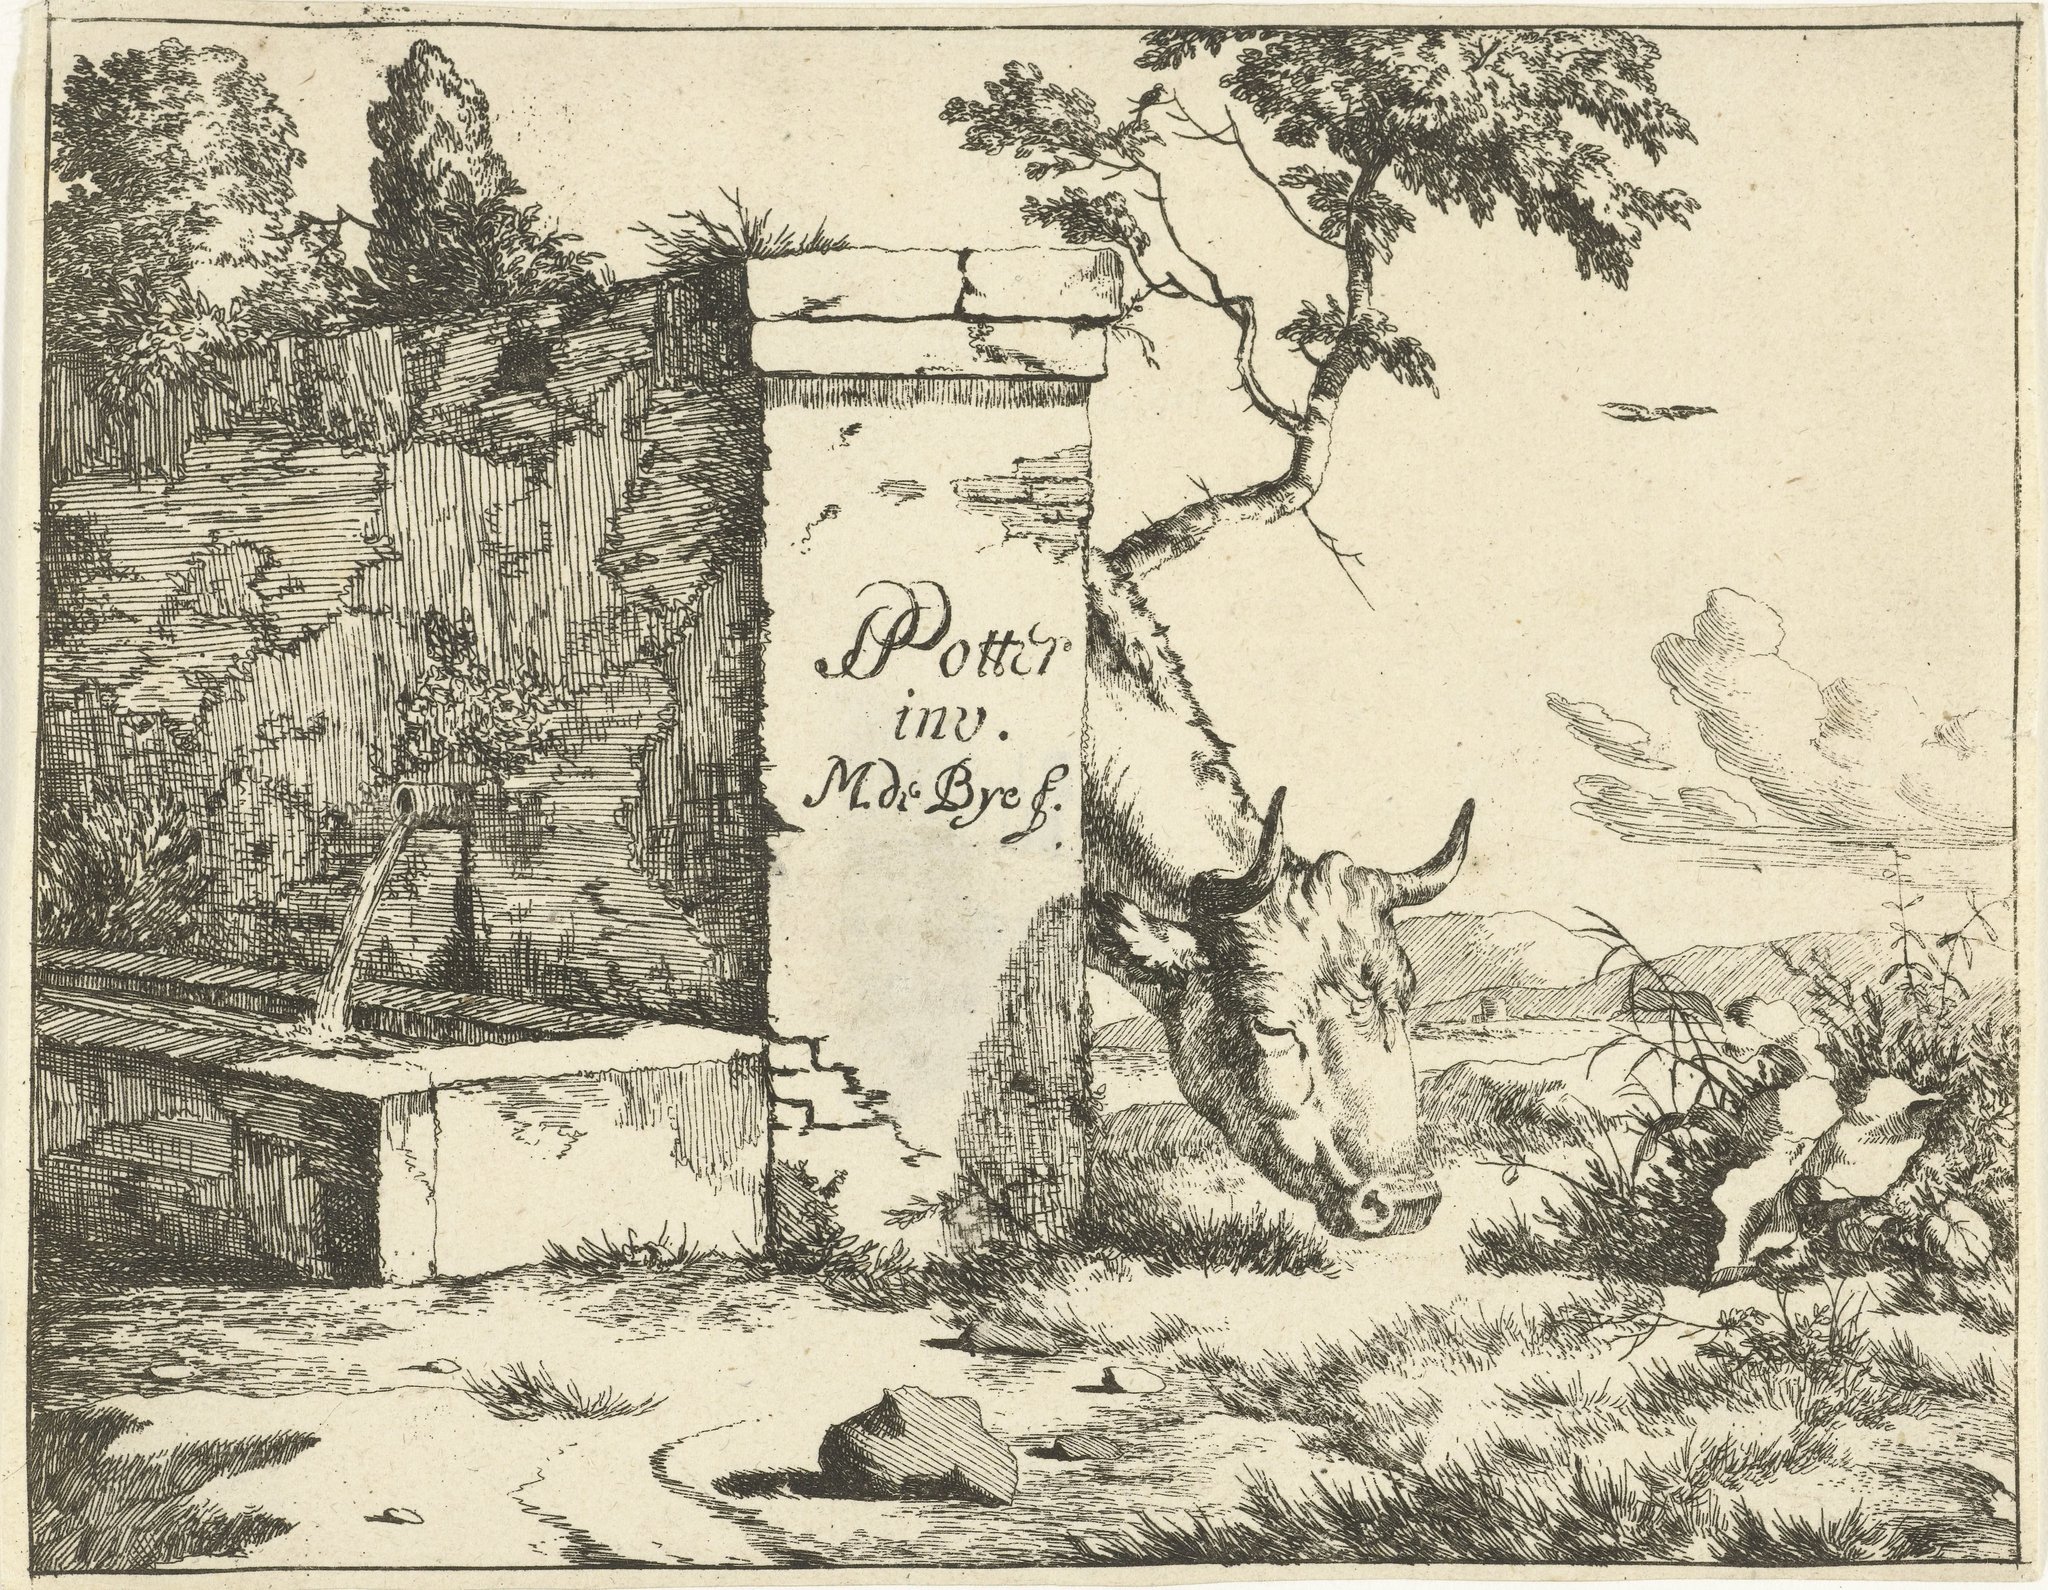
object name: titelprent, frontispice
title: Runderen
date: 1657-1677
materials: paper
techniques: etching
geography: the hague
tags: cow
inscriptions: collector's mark: Lugt 2166